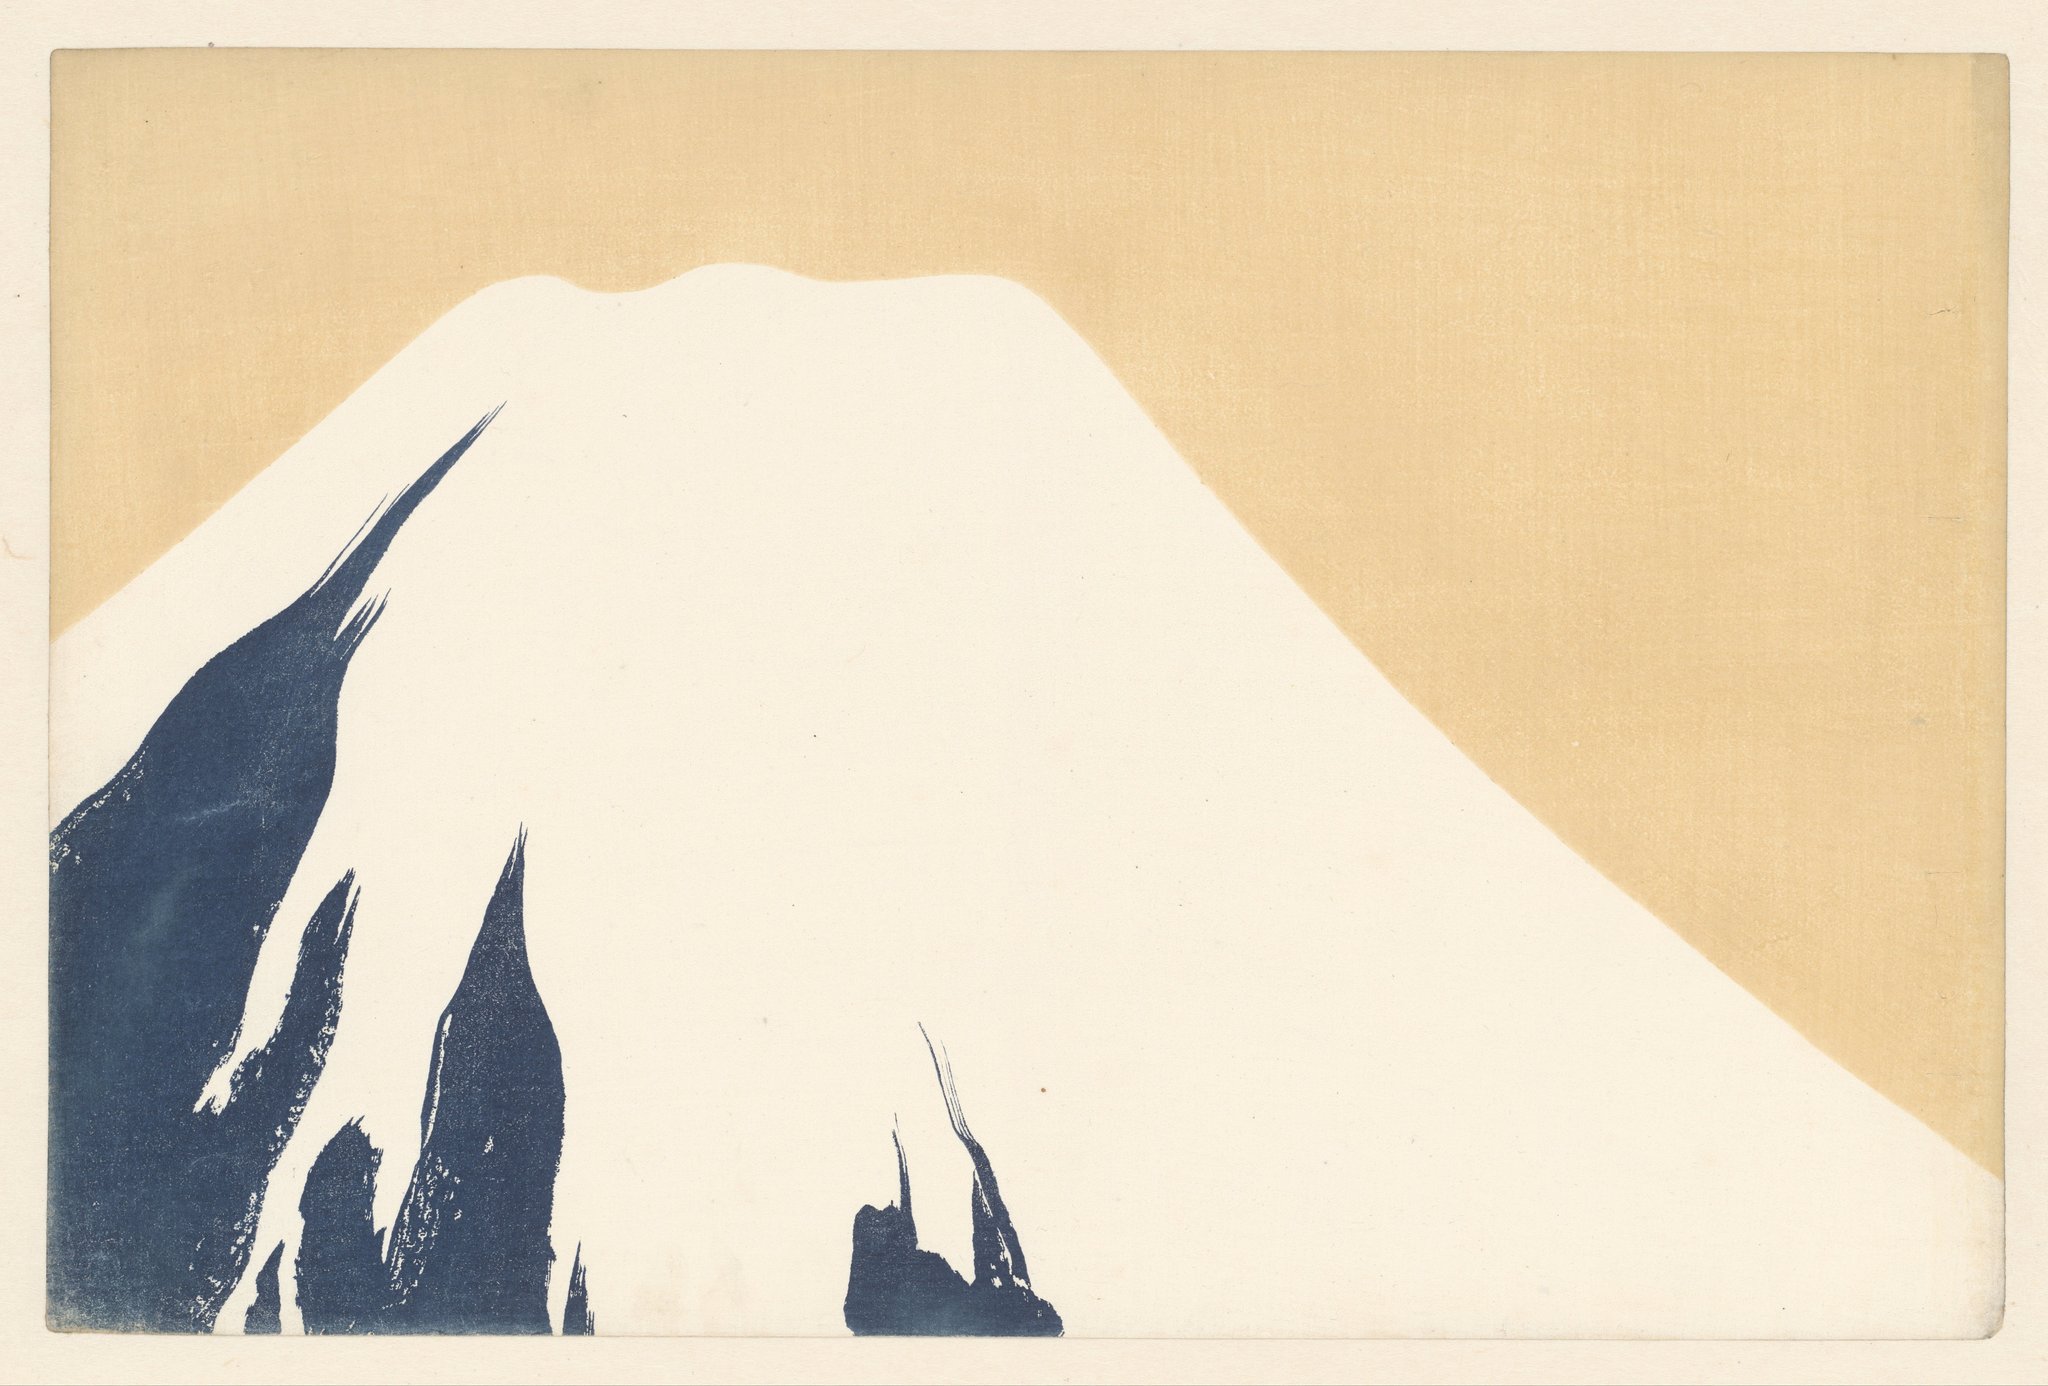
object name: print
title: De berg Fuji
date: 1909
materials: paper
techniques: woodcut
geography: kyoto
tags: mountain-top, peak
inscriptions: collector's mark: Lugt 2760, collector's mark: Lugt 2228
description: De top van de berg Fuji, bedekt met sneeuw, tegen een gele achtergrond.